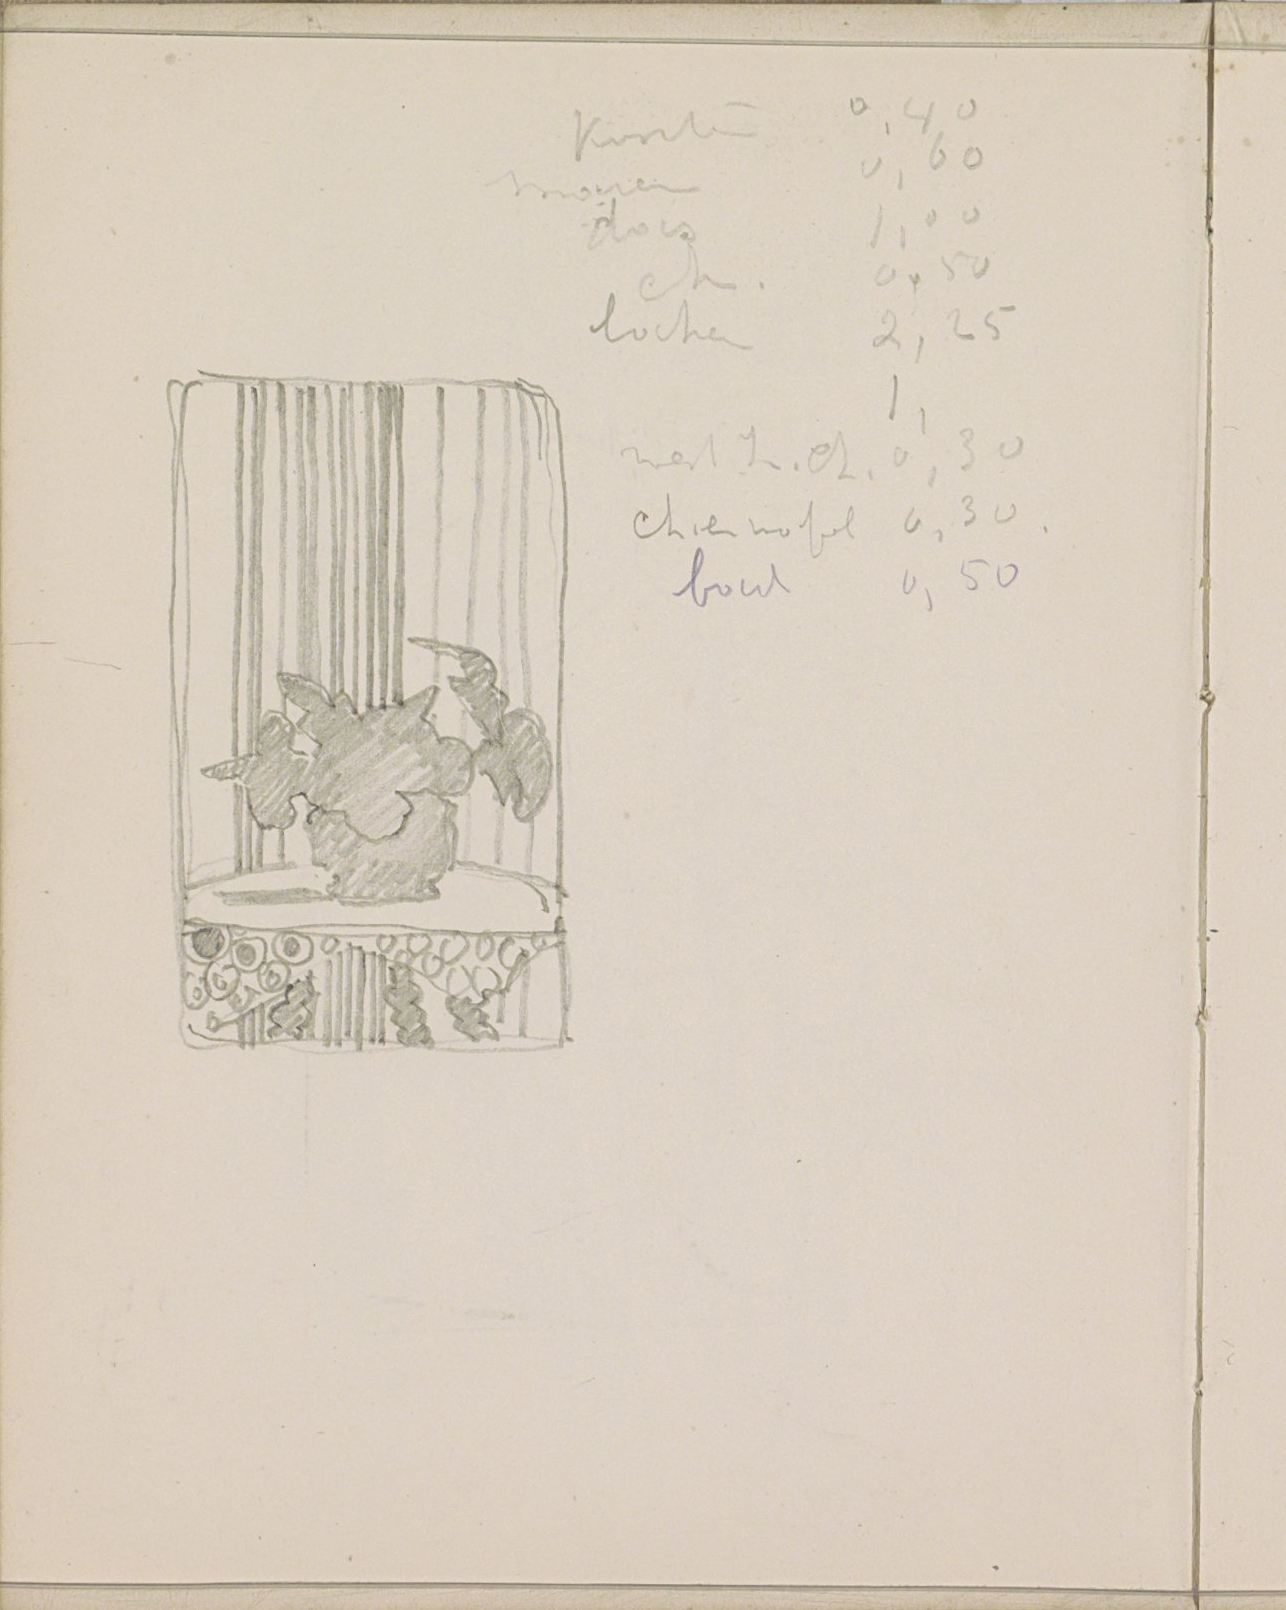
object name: sketchbook leaf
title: Vaas met bloemen op een tafel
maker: reijer stolk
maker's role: draughtsman, print maker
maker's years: 1896-1945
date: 1916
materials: paper, pencil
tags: flowers in a vase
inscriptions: annotation: ‘[...]’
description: Blad 21 verso uit een schetsboek met 72 bladen.